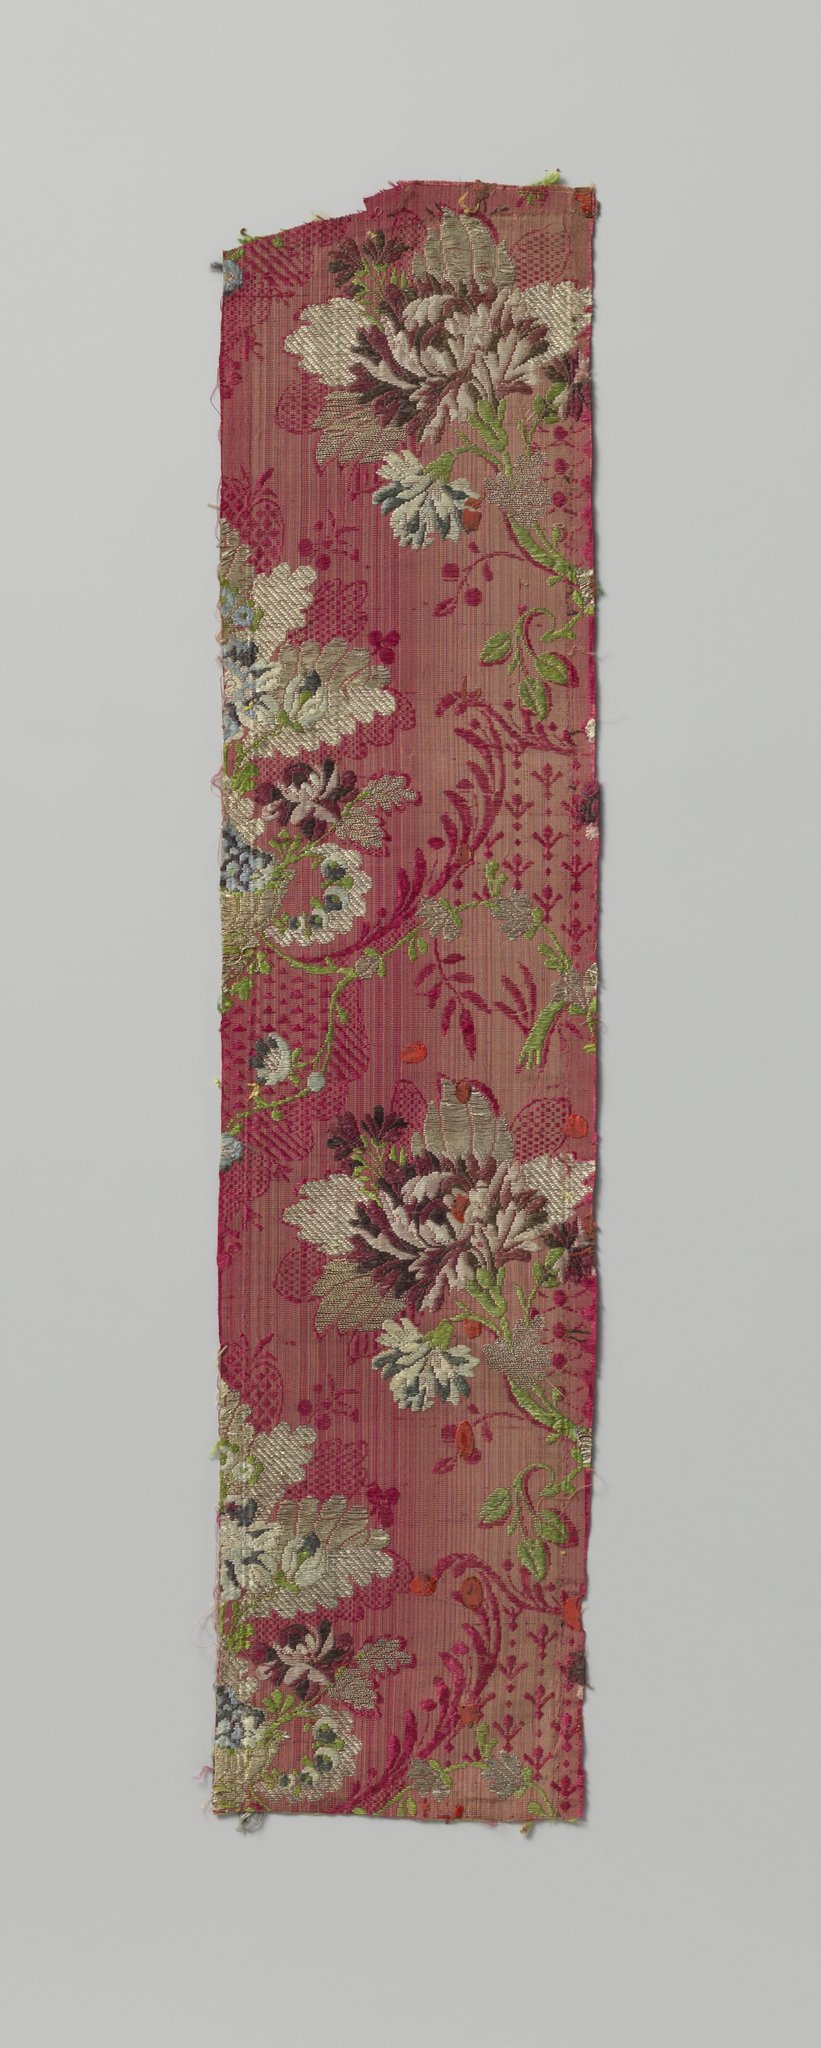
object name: fragment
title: Fragment rode gebrocheerde zijde met een veelkleurig patroon met boeket en bloemslingers en zogenaamde kantrand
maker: Anonymous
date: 1740-1760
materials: silk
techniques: brocade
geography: netherlands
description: Fragment van rode zijden grond met dito donkerder figuren, doorweven met veelkleurige boeketten en bloemslingers en zogenaamde kantrand.